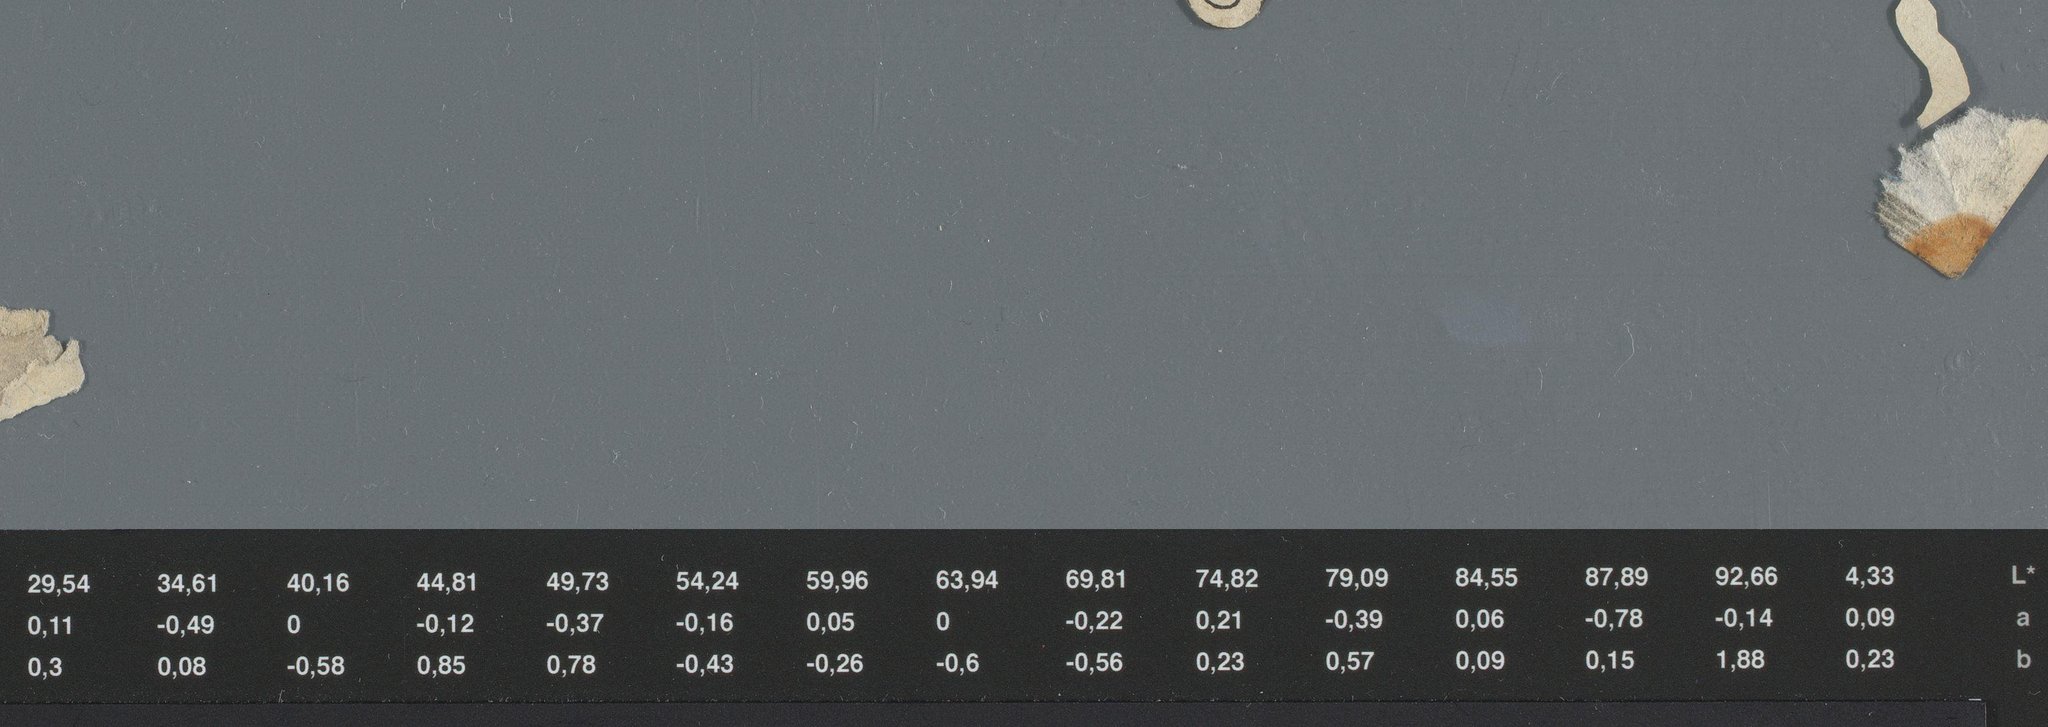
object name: print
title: Uitgeknipte details van prenten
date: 1585-1700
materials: paper